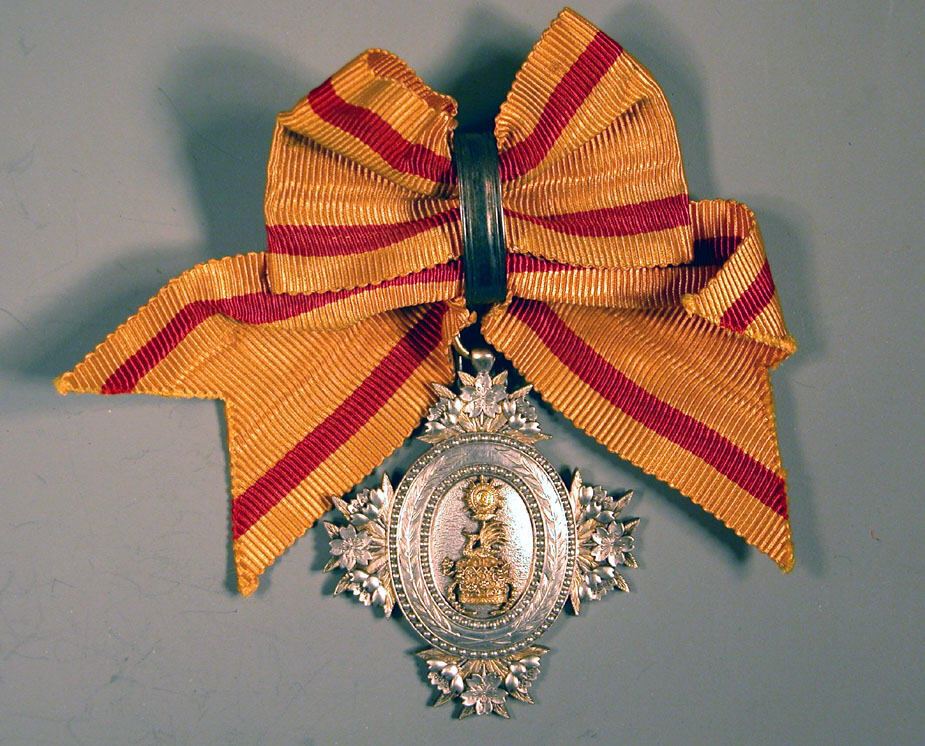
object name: medal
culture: japanese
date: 1867-1900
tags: flowers